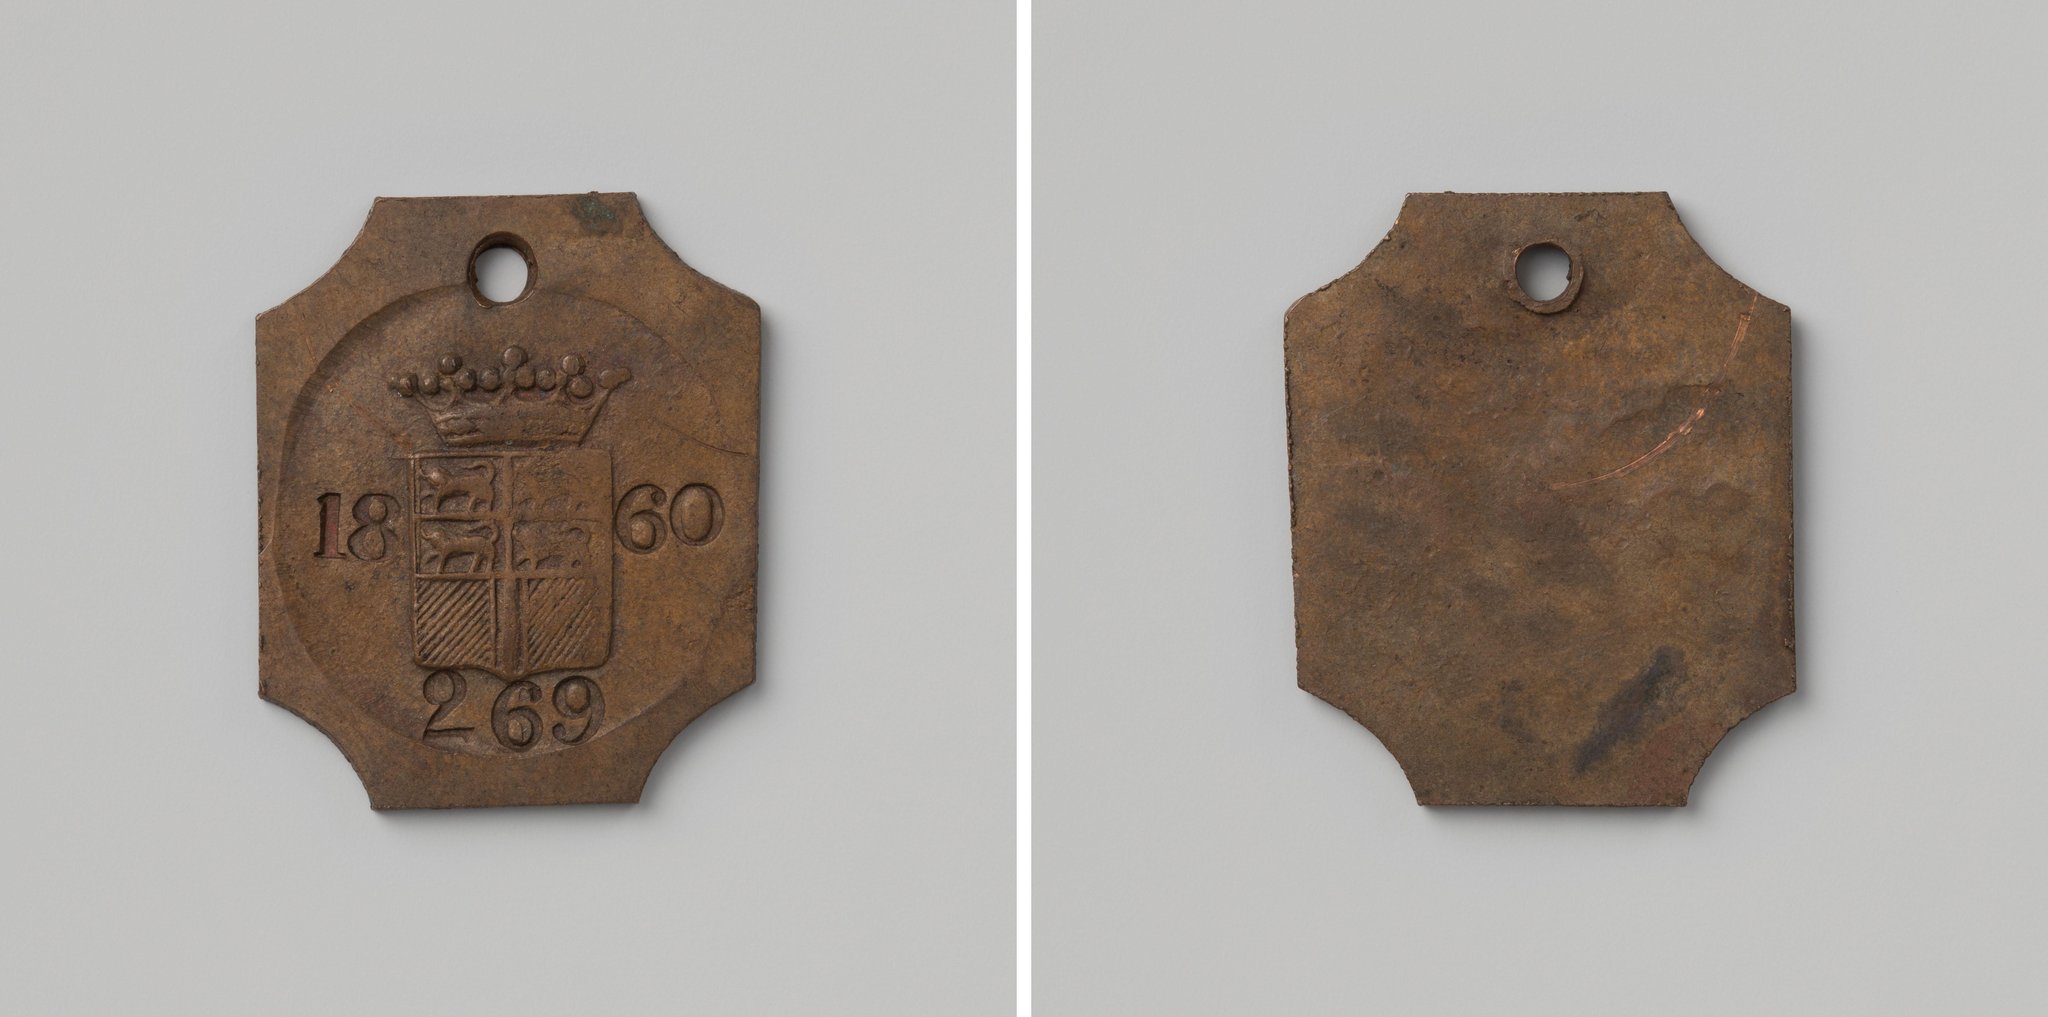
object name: hondenbelastingloodje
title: Stad Rotterdam, loodje met no. 269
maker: Anonymous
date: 1860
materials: copper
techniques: striking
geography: rotterdam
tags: rotterdam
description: eenzijdig, rechthoekig loodje met afgeschuinde, holle zijden en gat erin. Voorzijde: gekroond wapenschild tussen jaartal boven cijfer 269. Keerzijde: blanco